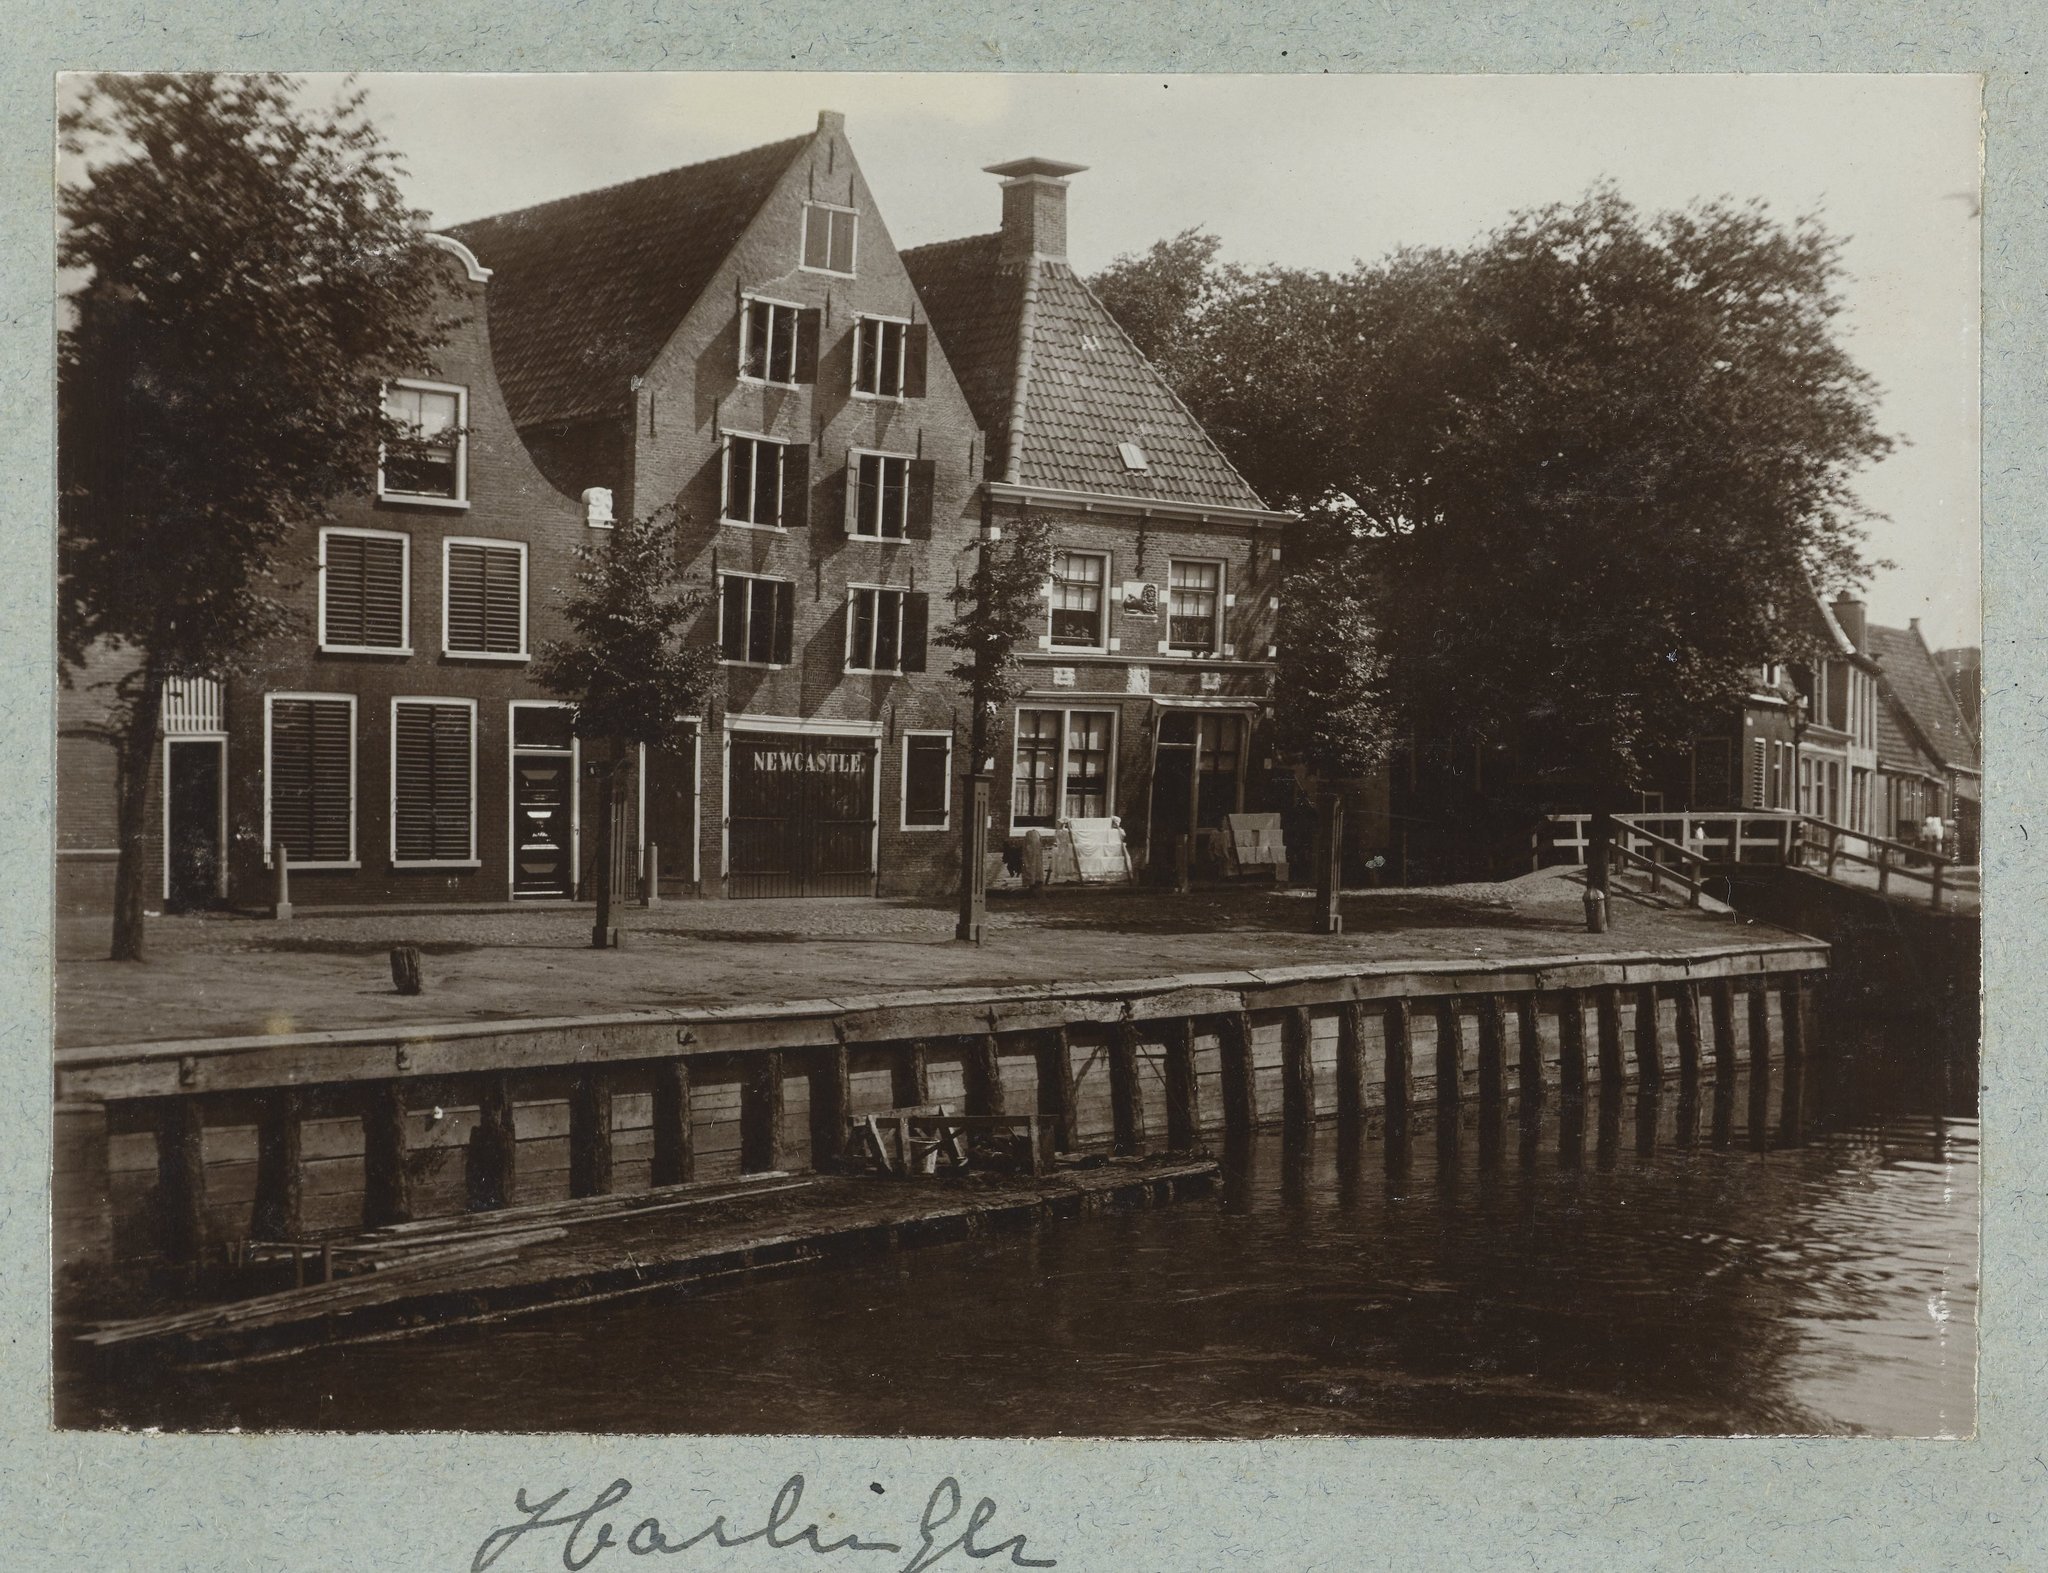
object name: photograph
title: Photographieën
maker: frits freerks fontein fz.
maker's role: fotograaf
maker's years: 1882-1928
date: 1898-1900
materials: cardboard, paper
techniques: gelatin silver print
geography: netherlands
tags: harlingen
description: Foto uit album 'Photographieën". Gezicht op de noordzijde van de Rommelhaven te Harlingen.